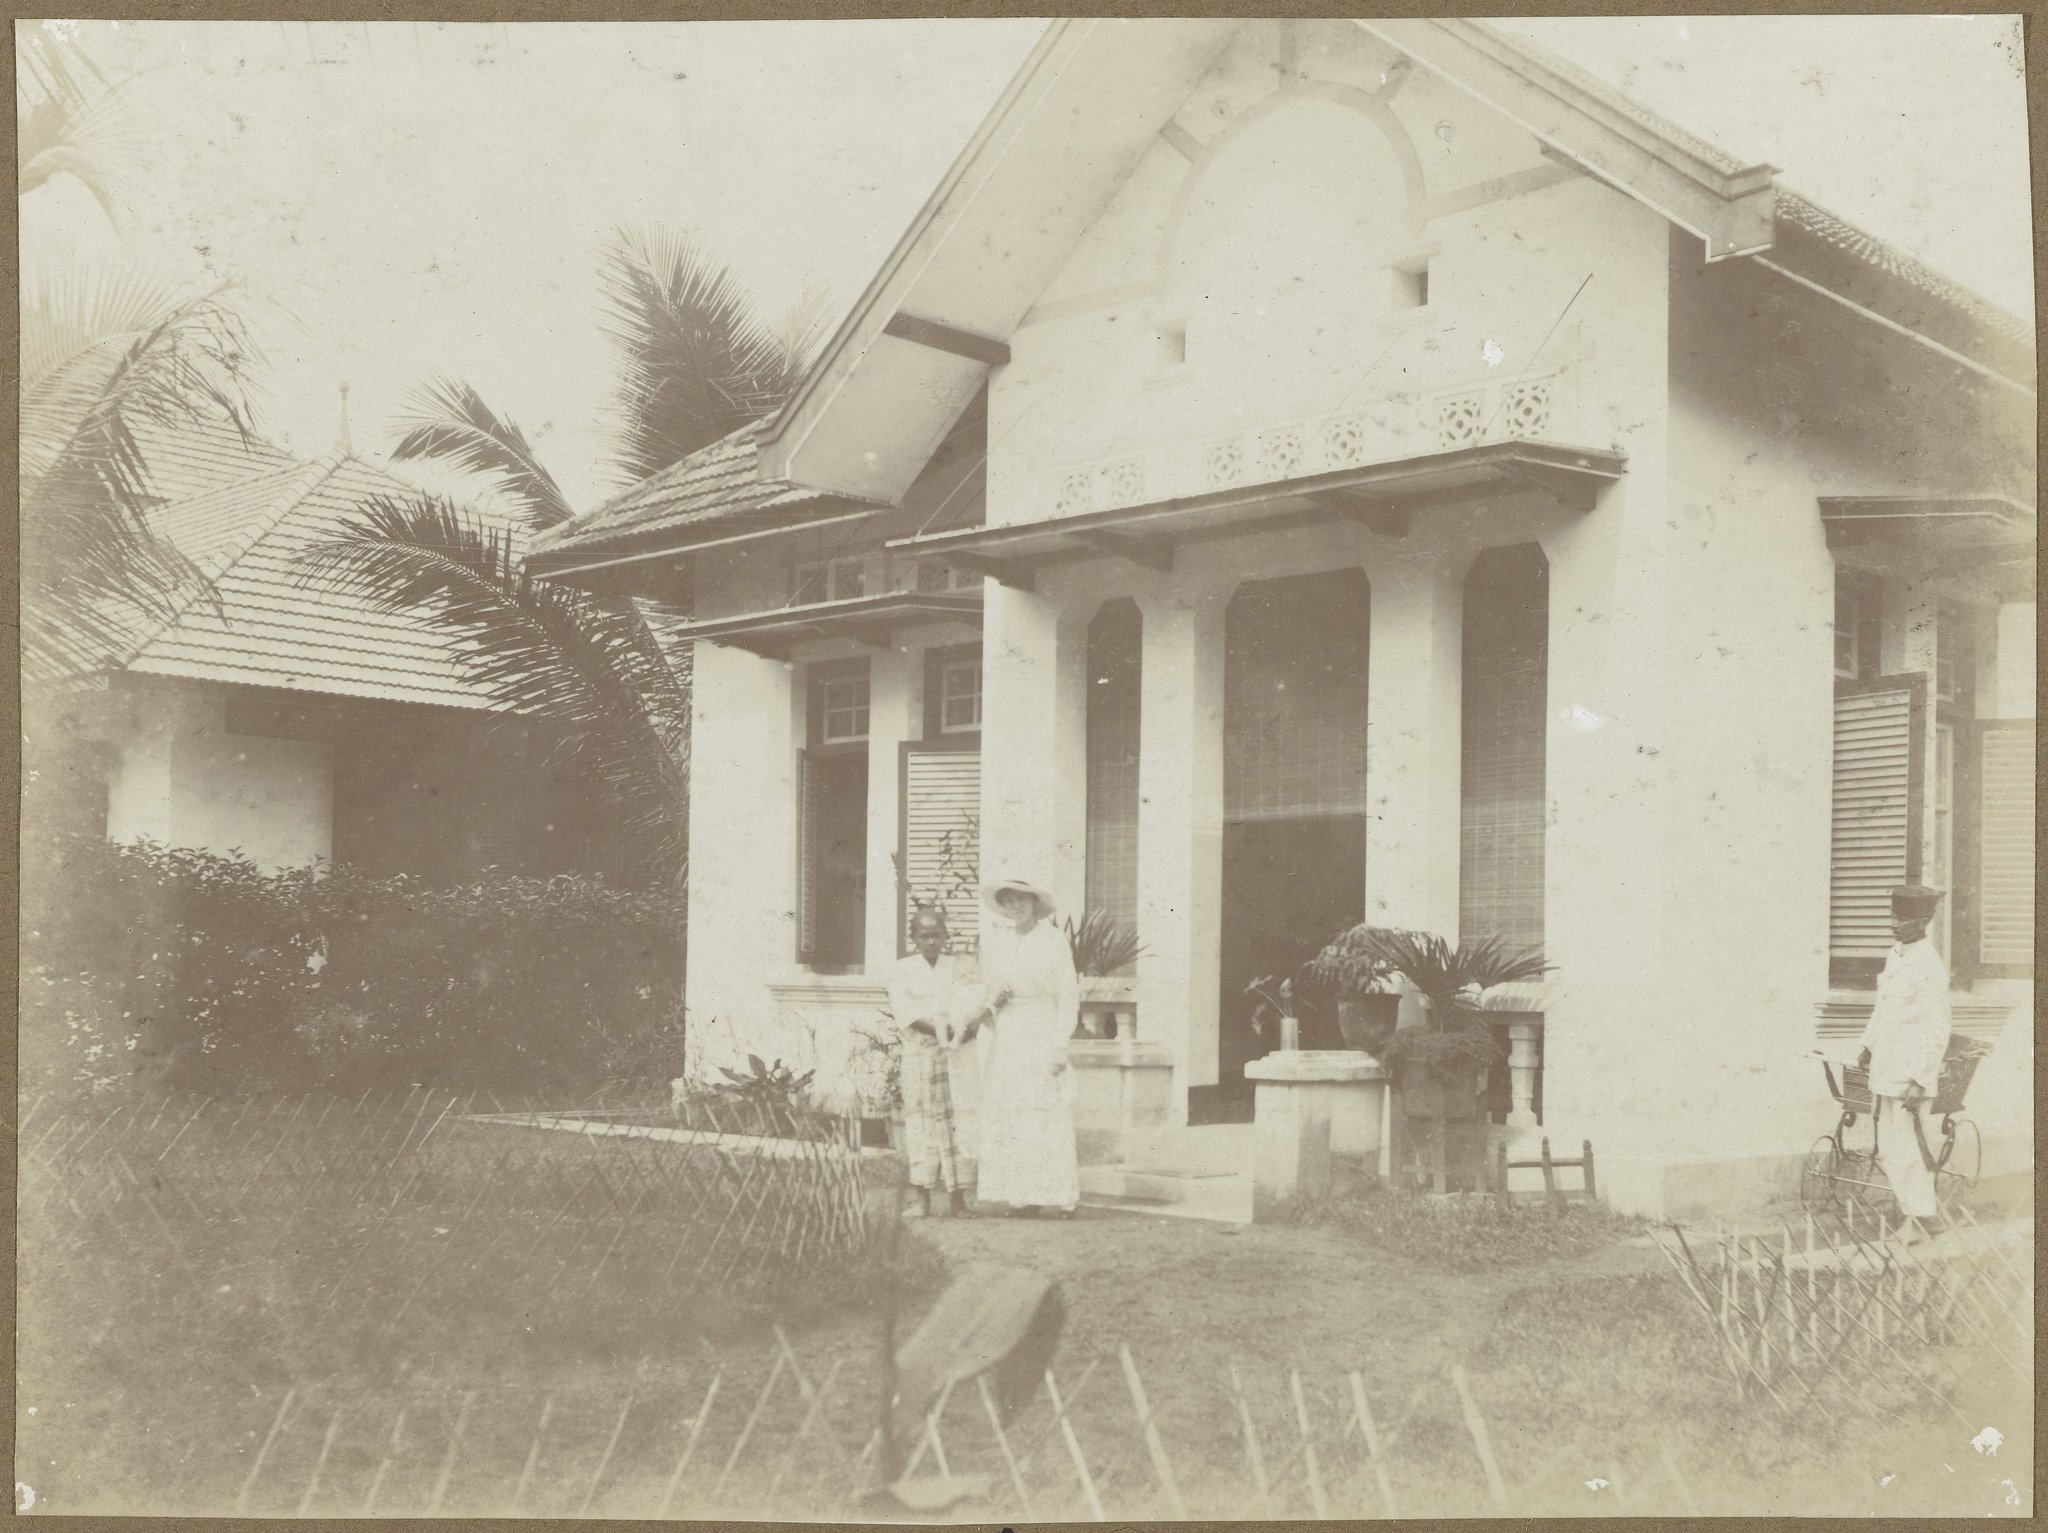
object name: photograph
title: Vrouw en zoon voor het huis aan de Wilhelminastraat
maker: Anonymous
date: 1916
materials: photographic support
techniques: gelatin silver print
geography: medan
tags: historical persons - bb - woman, family group, especially parents with their child(ren), detached house in city, representation of real building (either existing or having existed), architecture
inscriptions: inscription: ‘Medan - Wilhelminastraat 30 - met moeder en zoon / Geboortehuis W.G. Riphagen’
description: De vrouw van de architect Riphagen staande met hun pasgeboren zoon Willy (geboren in 1916) voor het huis aan de Wilhelminastraat 30 te Medan. Foto in het fotoalbum van het Nederlandse architectenbureau en aannemersbedrijf Bennink en Riphagen te Medan in de jaren ca. 1914-1919.